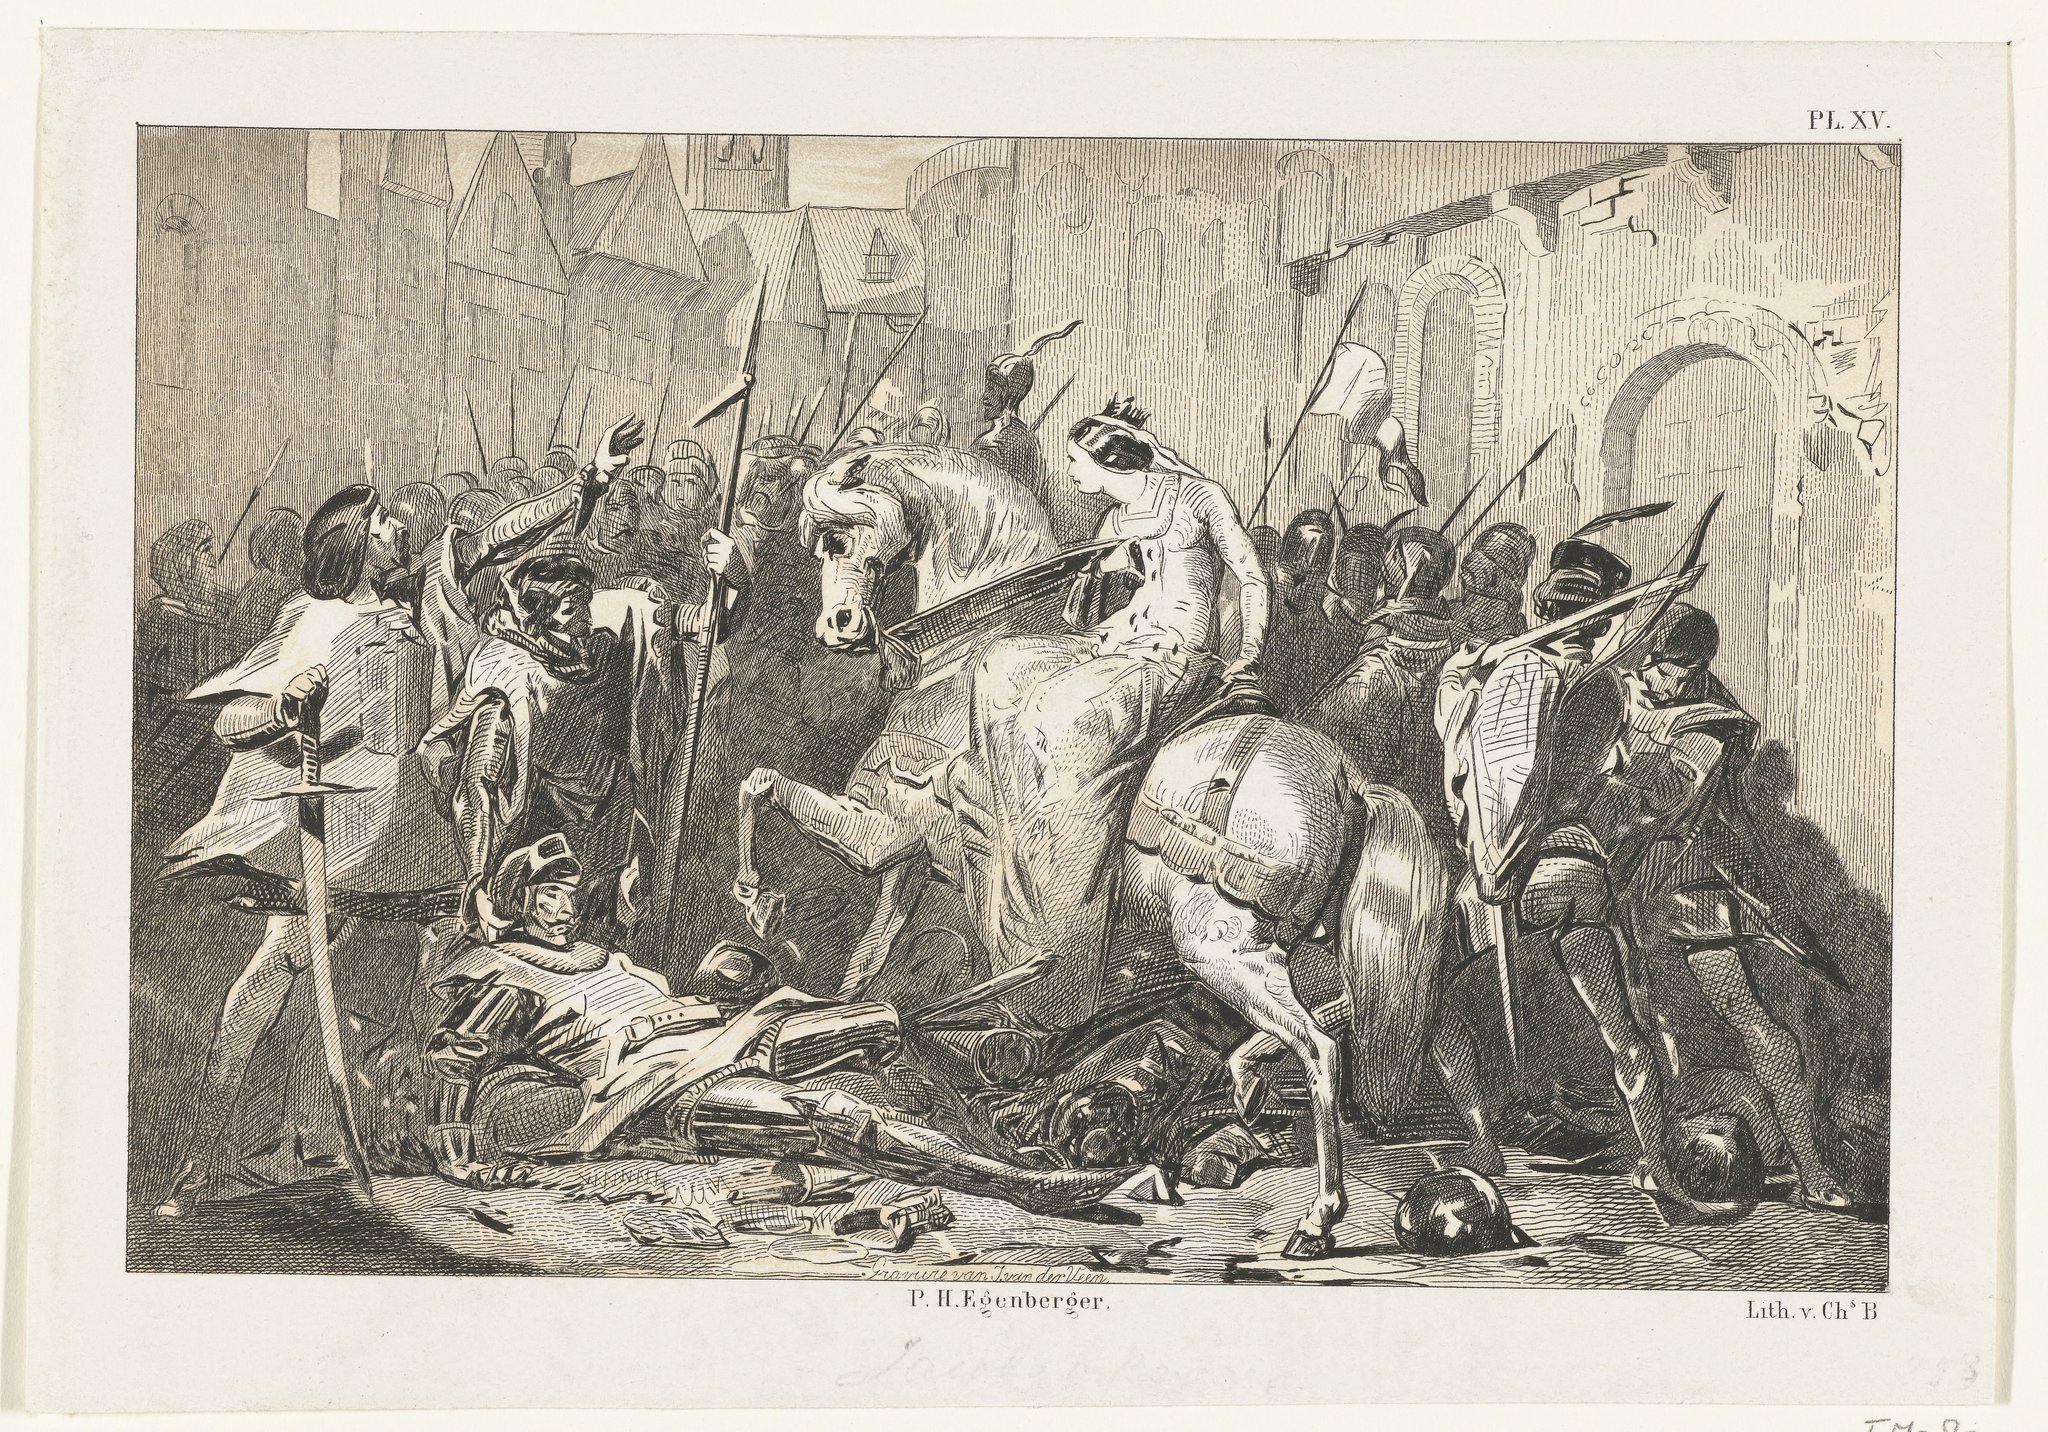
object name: print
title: Jacoba van Beieren stelt zich aan het hoofd van de Hoeken, ca. 1430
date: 1853-1855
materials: paper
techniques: lithograph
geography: netherlands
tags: jacoba of bavaria (countess of hainaut), battle, fighting in general, netherlands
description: Illustratie voor: Jacob van Lennep, De geschiedenis des vaderlands in schetsen en afbeeldingen, Binger, Amsterdam 1855, 8 delen, pl. XV.